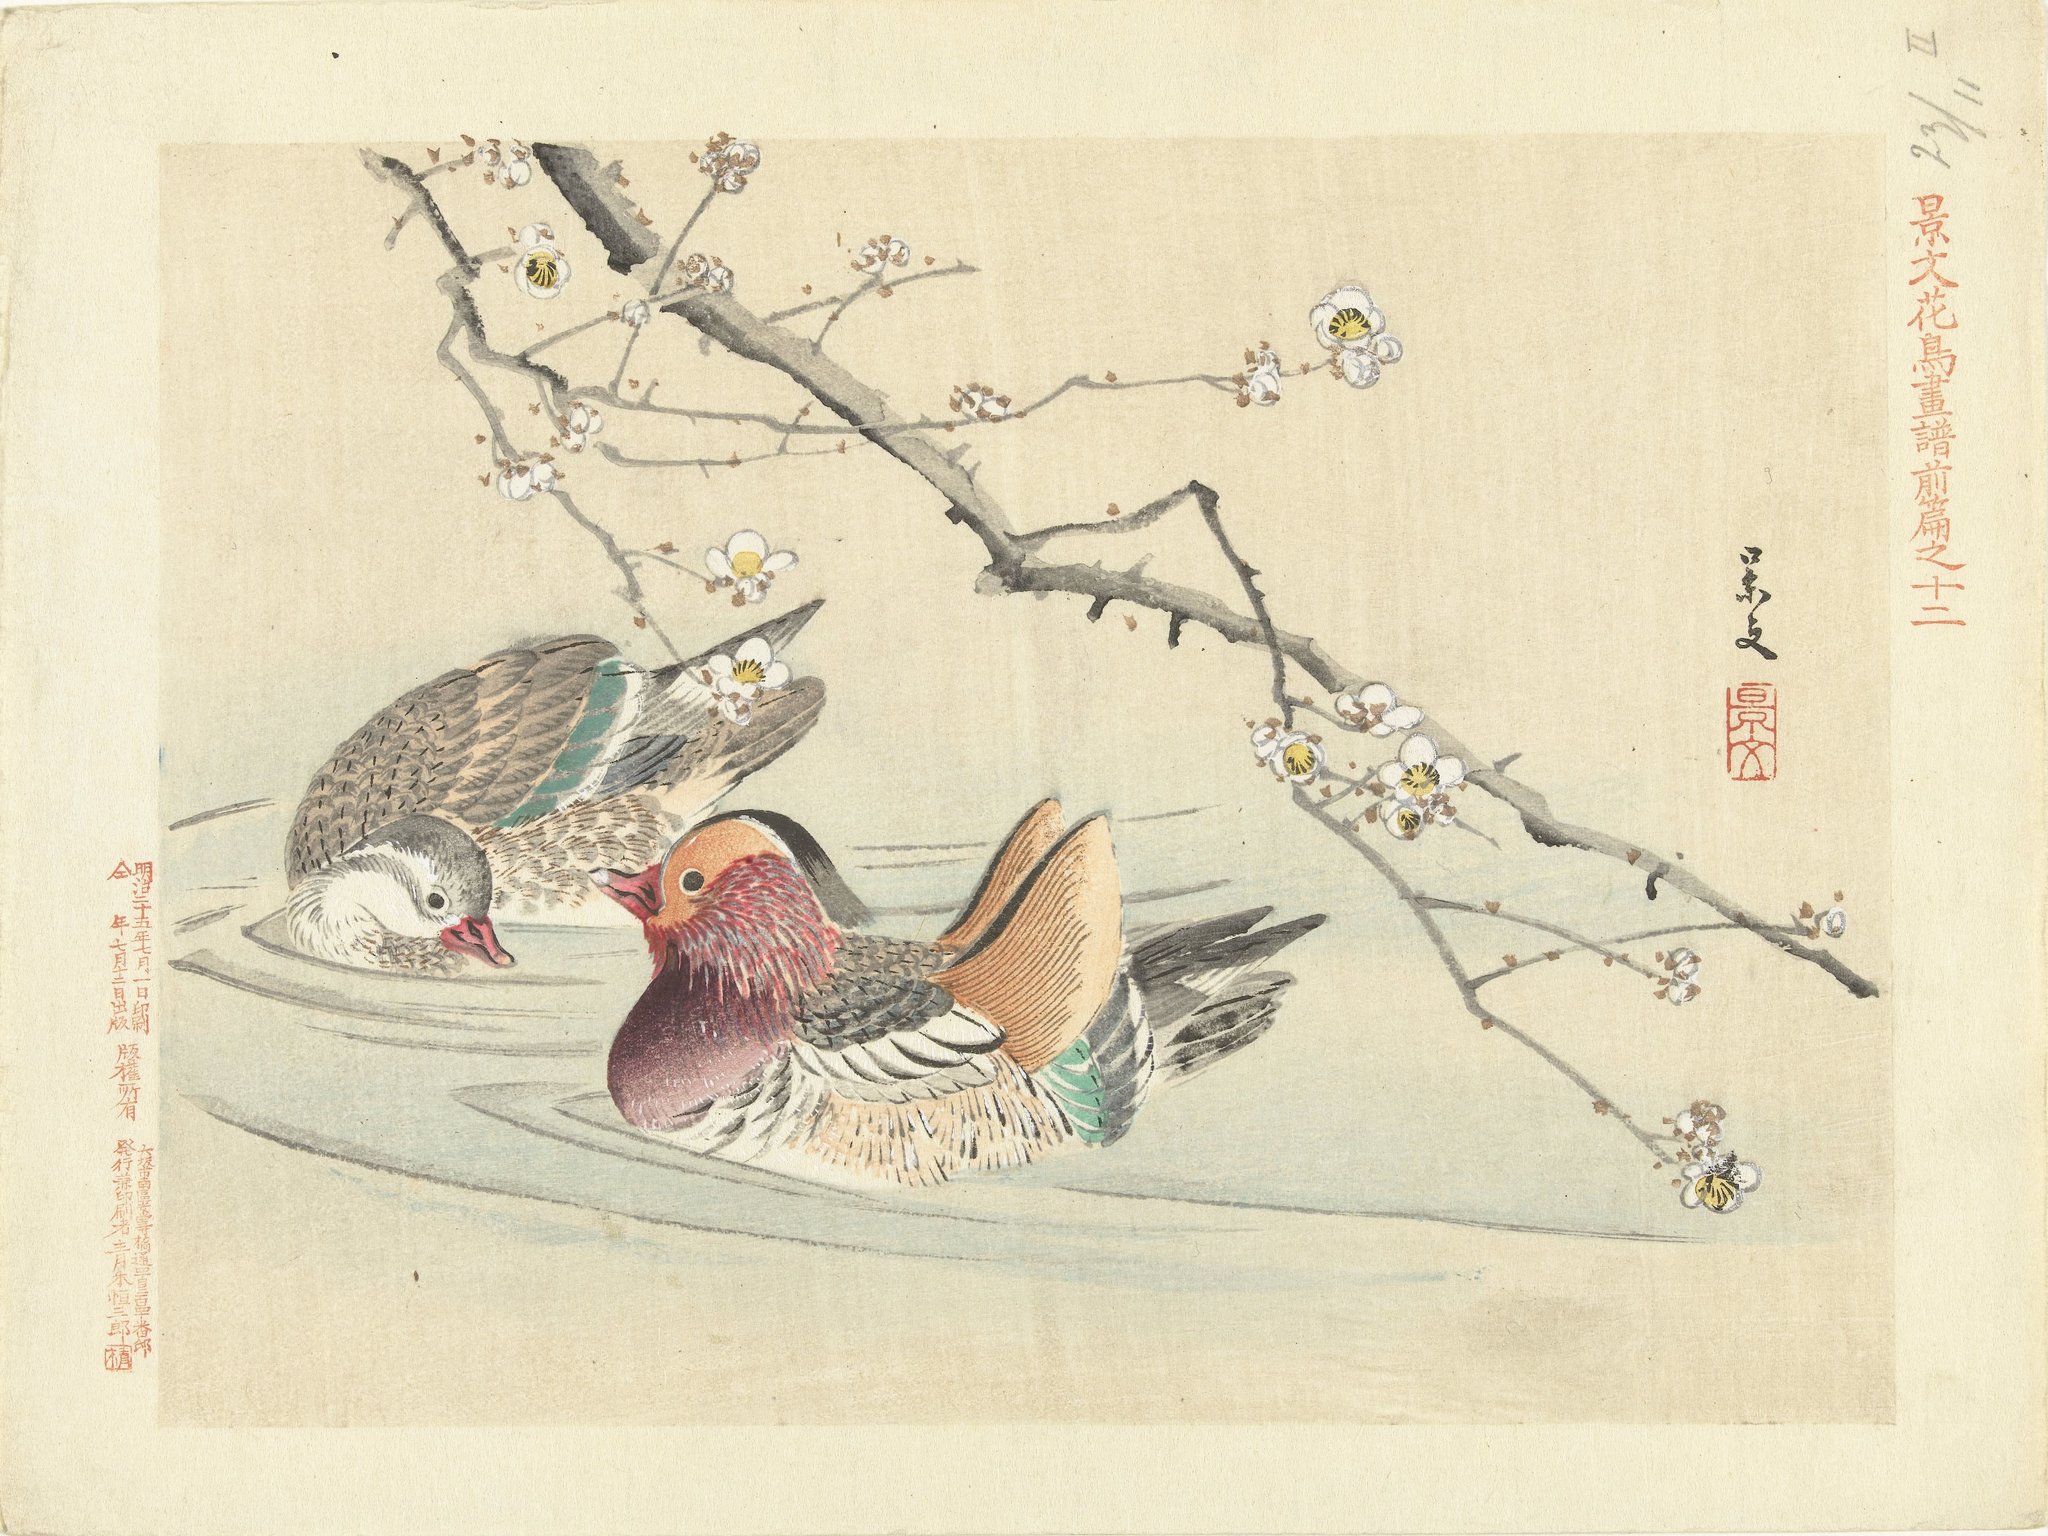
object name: print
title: Bloemen- en vogelschetsen van Keibun- deel één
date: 1807-1892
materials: paper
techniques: woodcut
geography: osaka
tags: water-birds: duck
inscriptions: collector's mark: Lugt 2228, collector's mark: ‘Rijksschool voor kunstnijverheid’ Lugt 3937